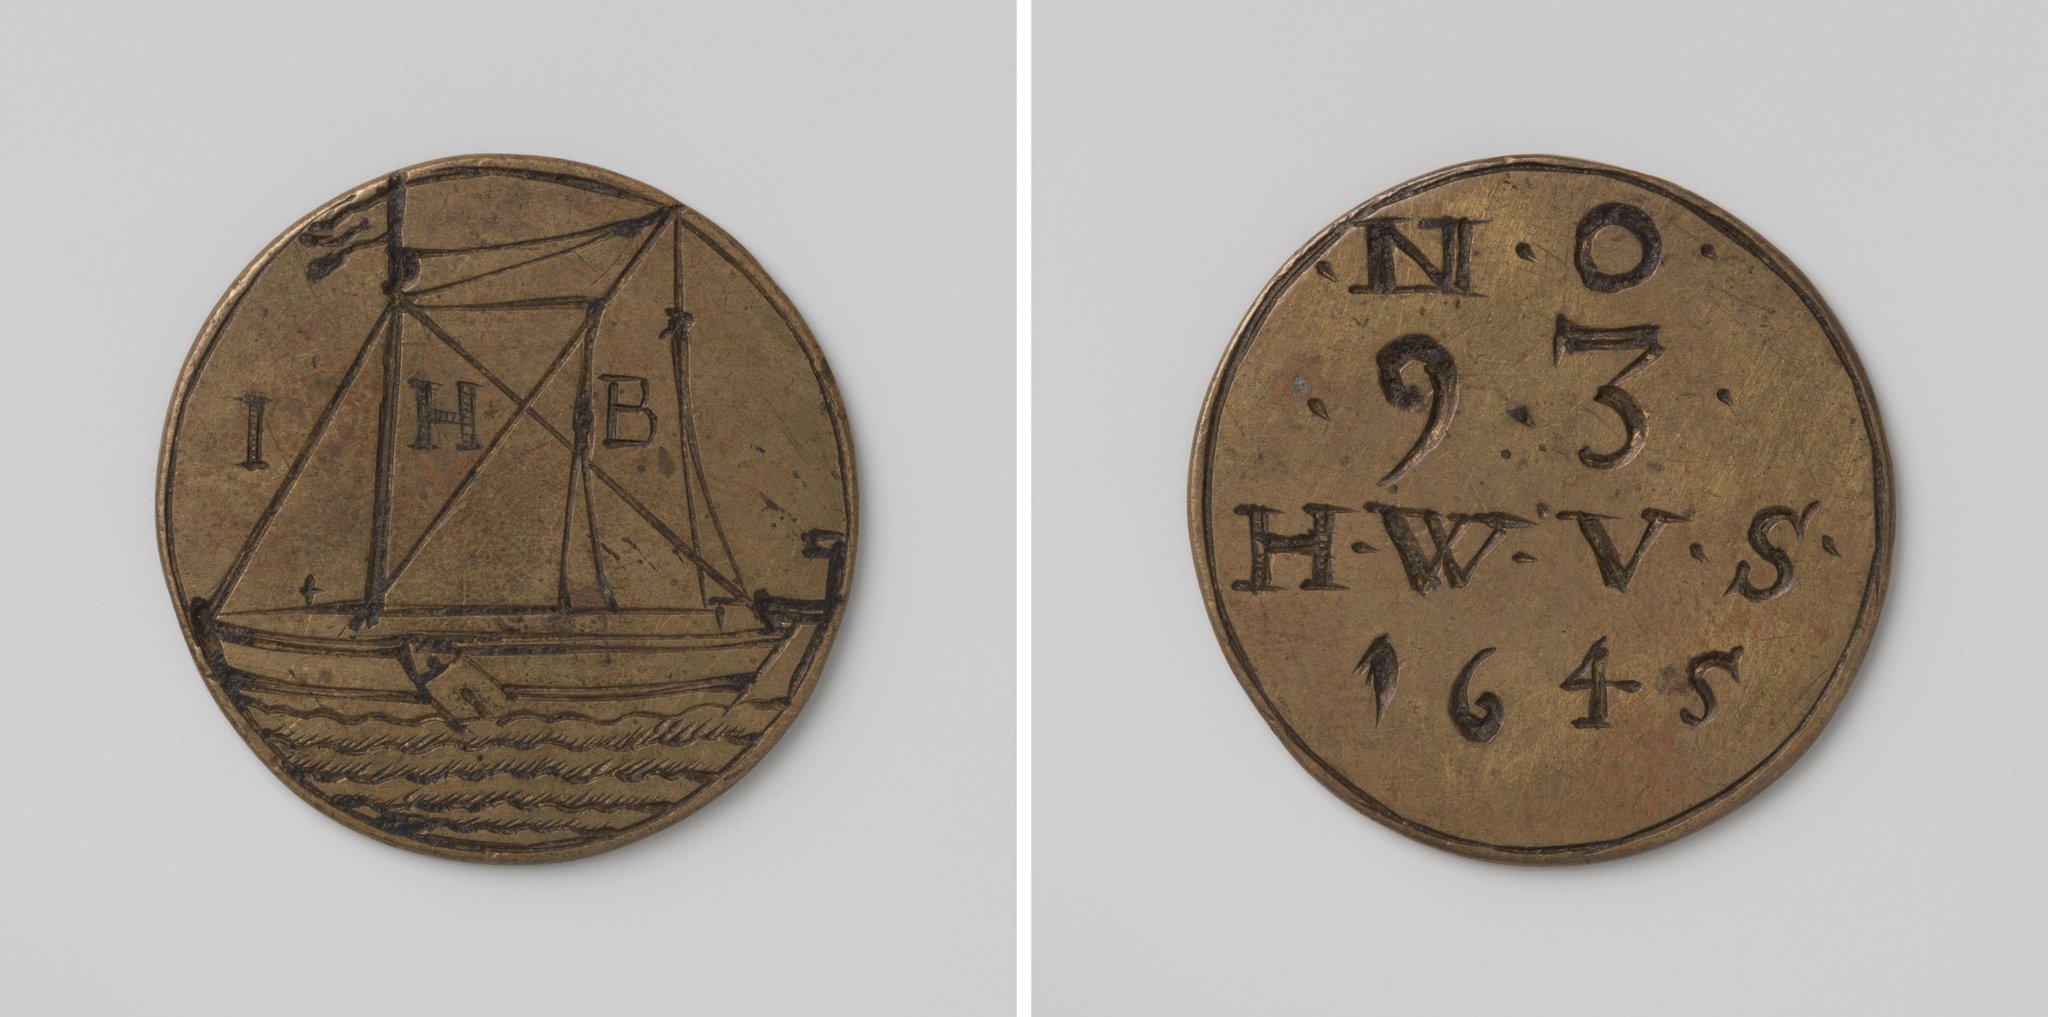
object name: medal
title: Klein schippersgilde van Rotterdam, gildepenning met no. 93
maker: Anonymous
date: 1645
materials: brass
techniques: engraving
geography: rotterdam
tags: rotterdam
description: Messing penning. Voorzijde: naar links varend zeilschip; in de zielen: letters I, H en B. Keerzijde: opschrift: N.O. 9.3, de letters H, W, V en S boven jaartal